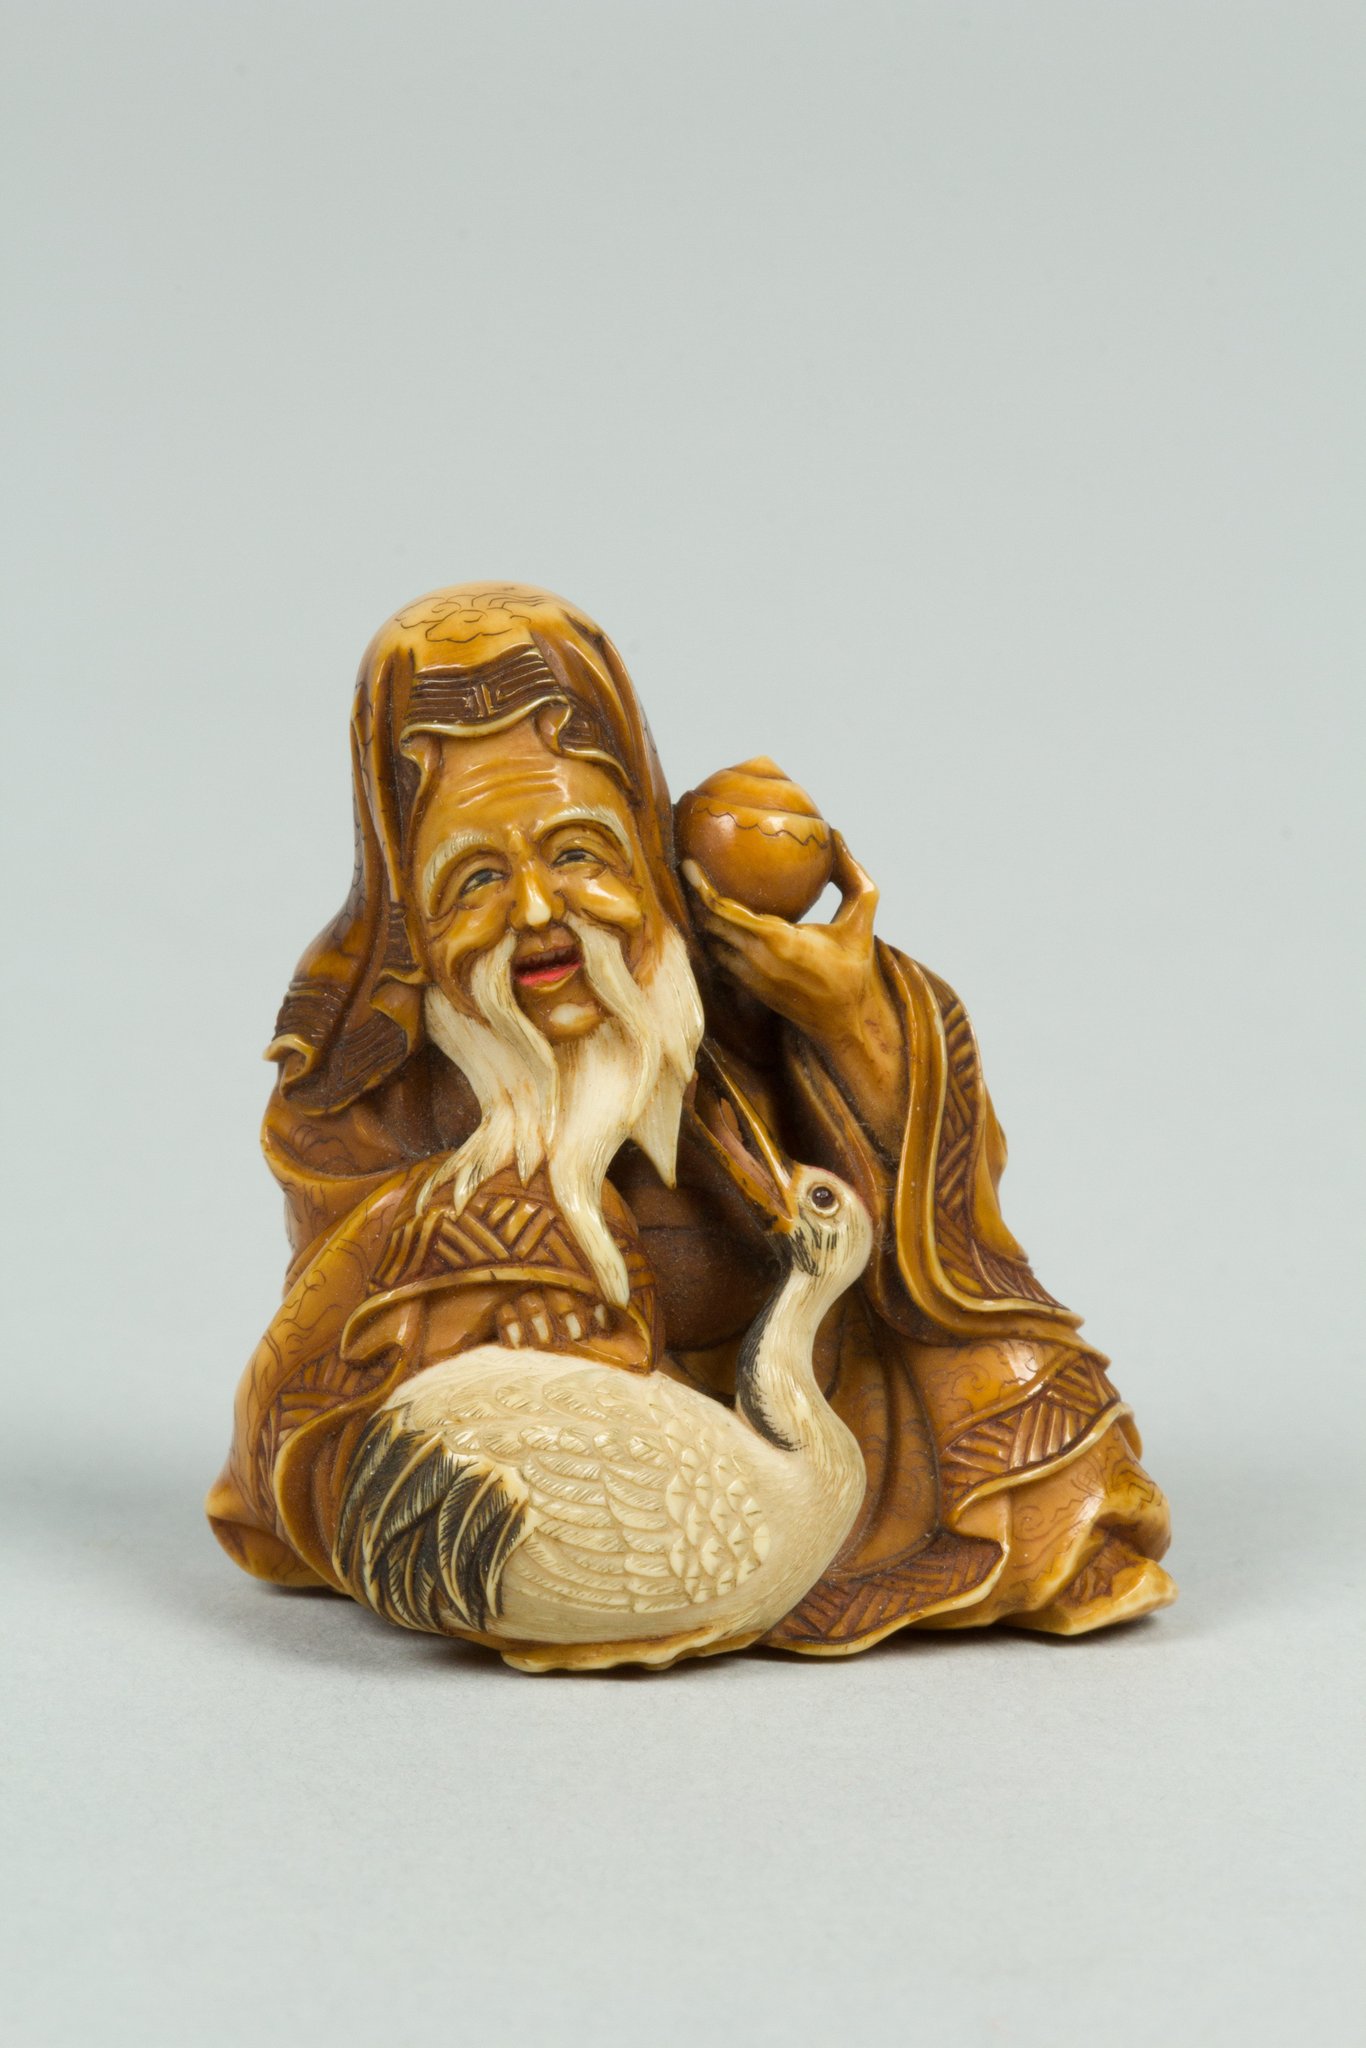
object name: netsuke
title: Netsuke of Old Man and Stork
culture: japanese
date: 1801-1900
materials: ivory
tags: birds